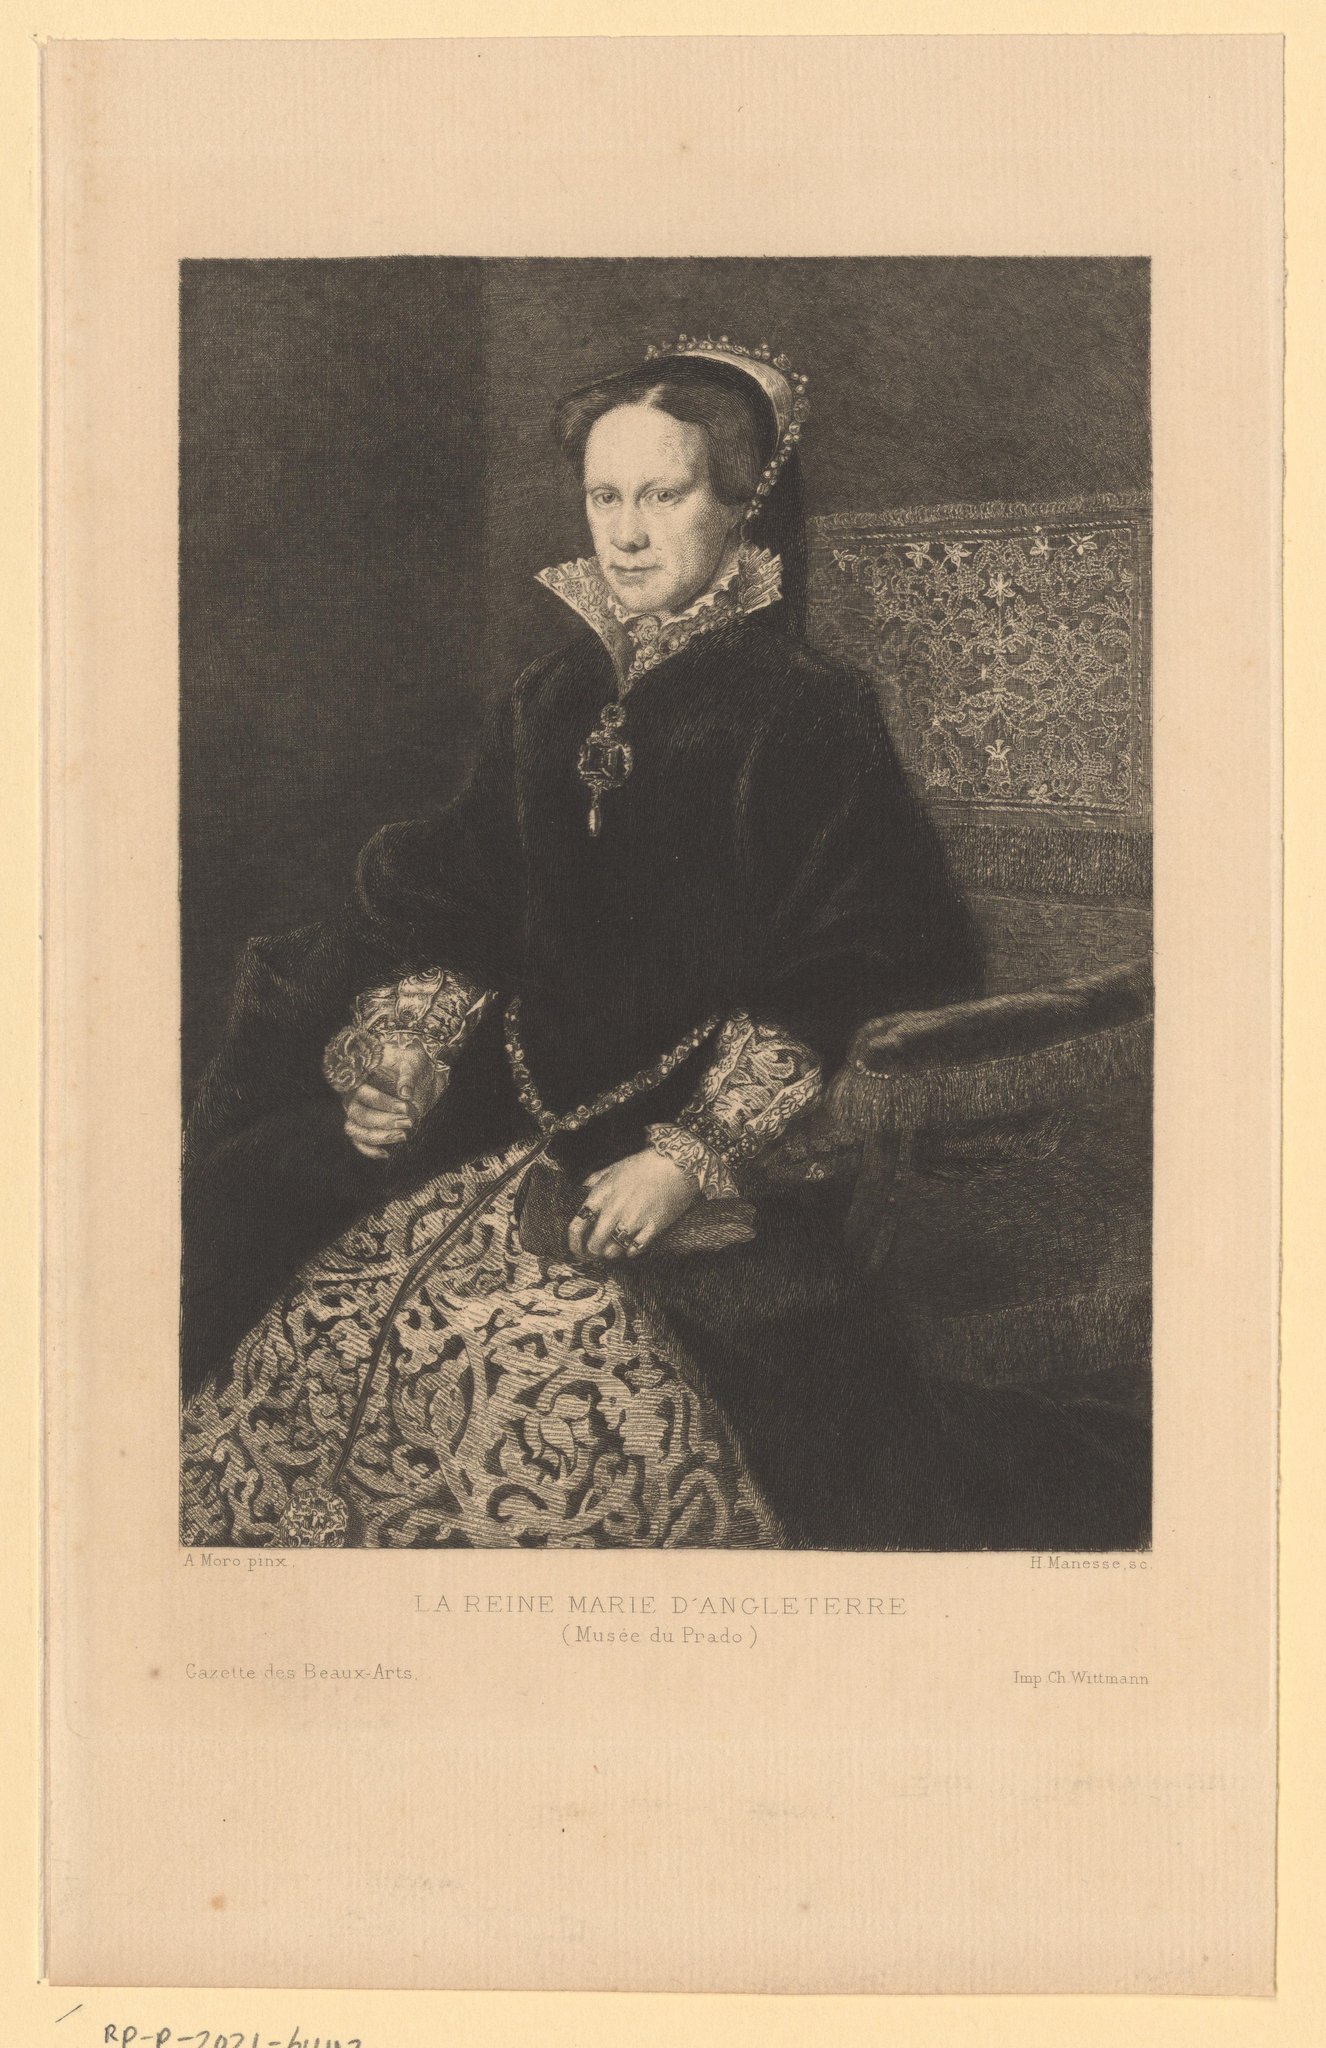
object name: print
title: Portret van Maria I van Engeland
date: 1893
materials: paper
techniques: etching, intaglio, retroussage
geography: france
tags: london, historical persons - bb - woman, queen, throne, flowers: rose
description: Prent waarschijnlijk uit: Gazette des beaux-arts 9 (1893).